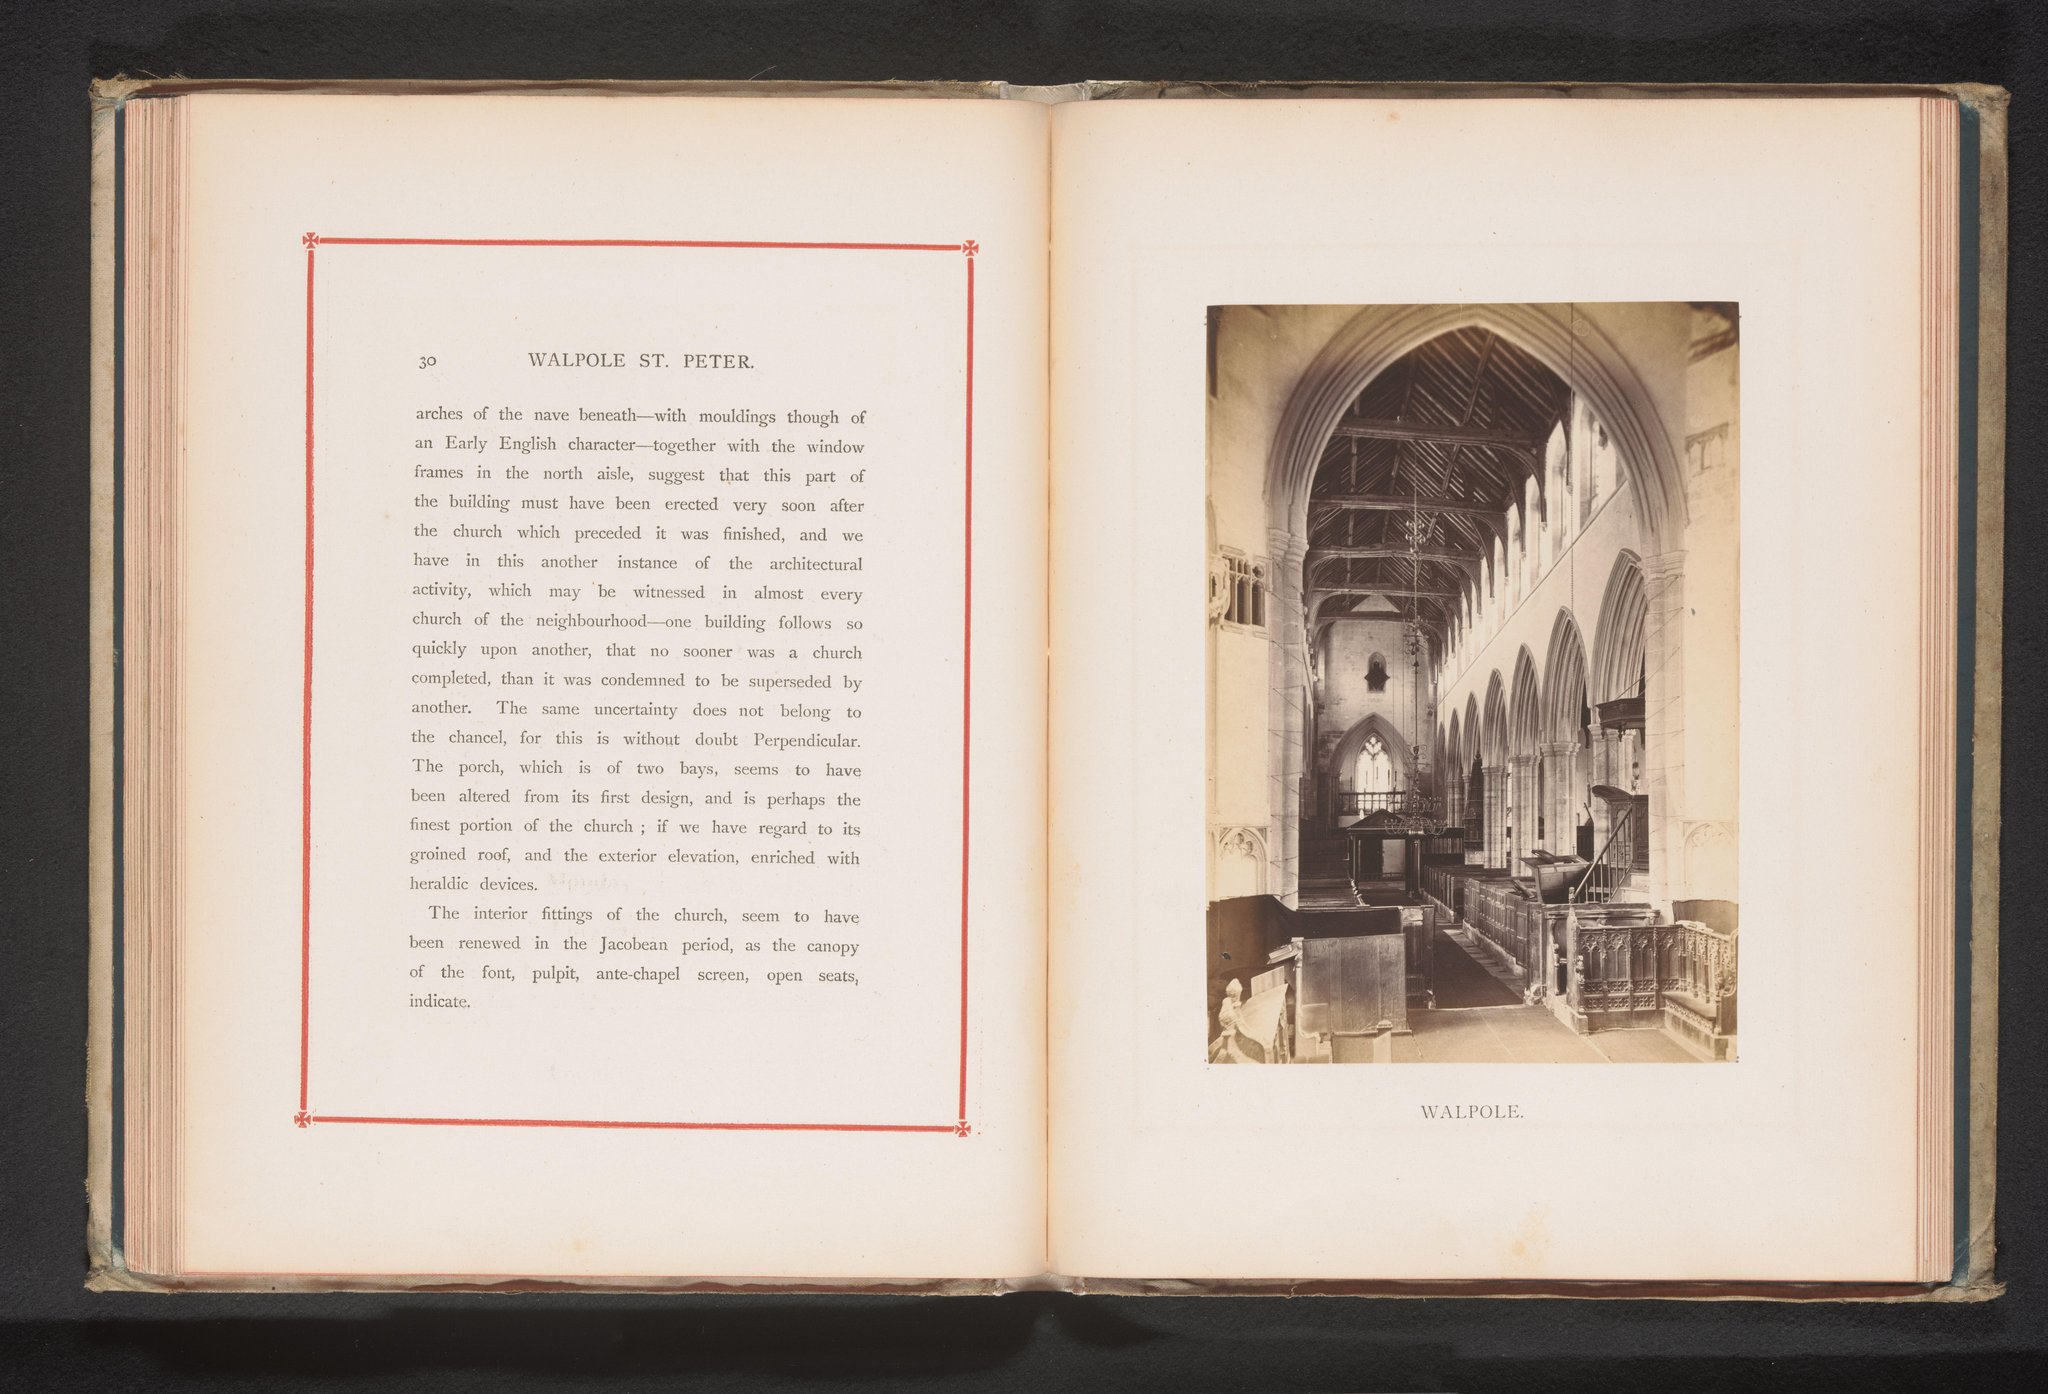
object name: photograph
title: Walpole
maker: edward johnson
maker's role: fotograaf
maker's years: 1822-1907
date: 1858-1869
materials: photographic support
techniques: albumen print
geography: saint peter's church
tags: parts of church interior: aisle, interior of church